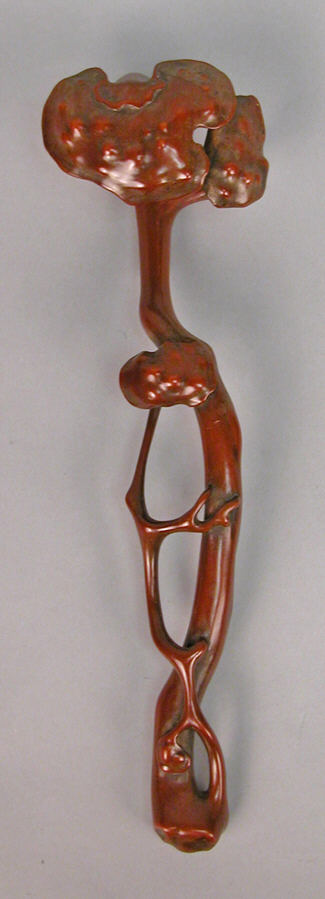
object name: accessory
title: Ruyi Scepter in the Shape of a Fungus of Longevity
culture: chinese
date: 1601-1800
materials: wood